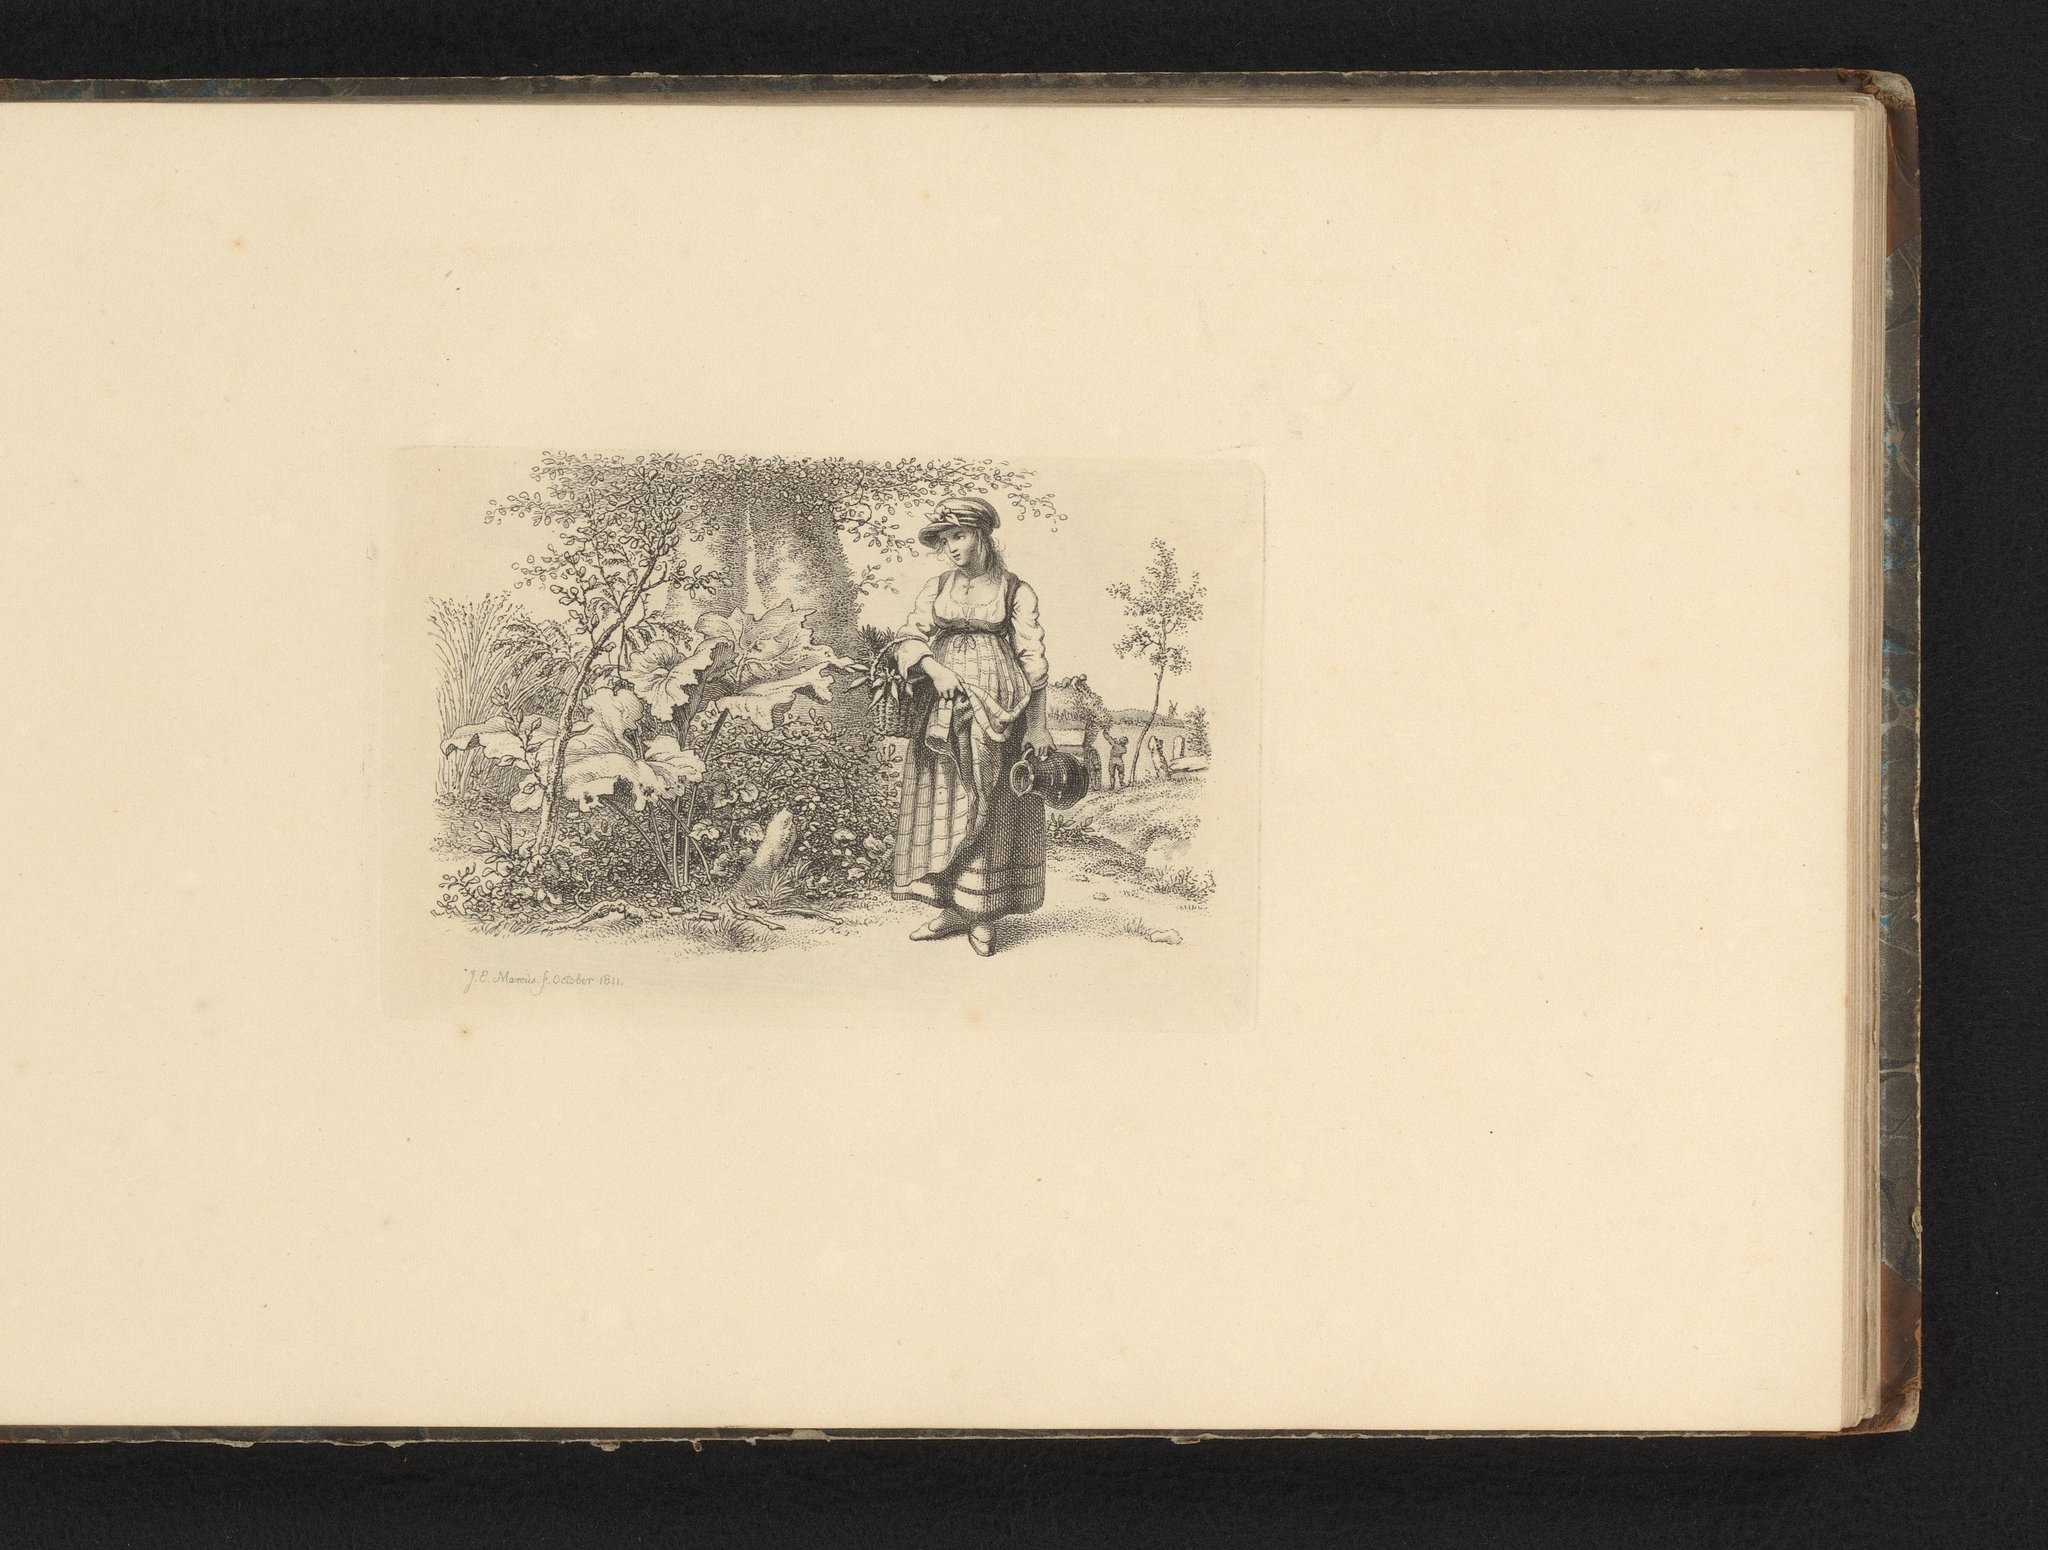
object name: album leaf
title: Landschap met boerin met mand en kruik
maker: jacob ernst marcus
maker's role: draughtsman, print maker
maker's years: 1774-1826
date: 1810-1811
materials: paper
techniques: etching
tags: adolescent, young woman, maiden, jar, jug (used as drinking-vessel), container made of plant material other than wood: basket, rest during harvest (eating, dancing, making love, etc.)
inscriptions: date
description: Op de achtergrond wordt een hooiwagen beladen. Deze prent maakt deel uit van een album.